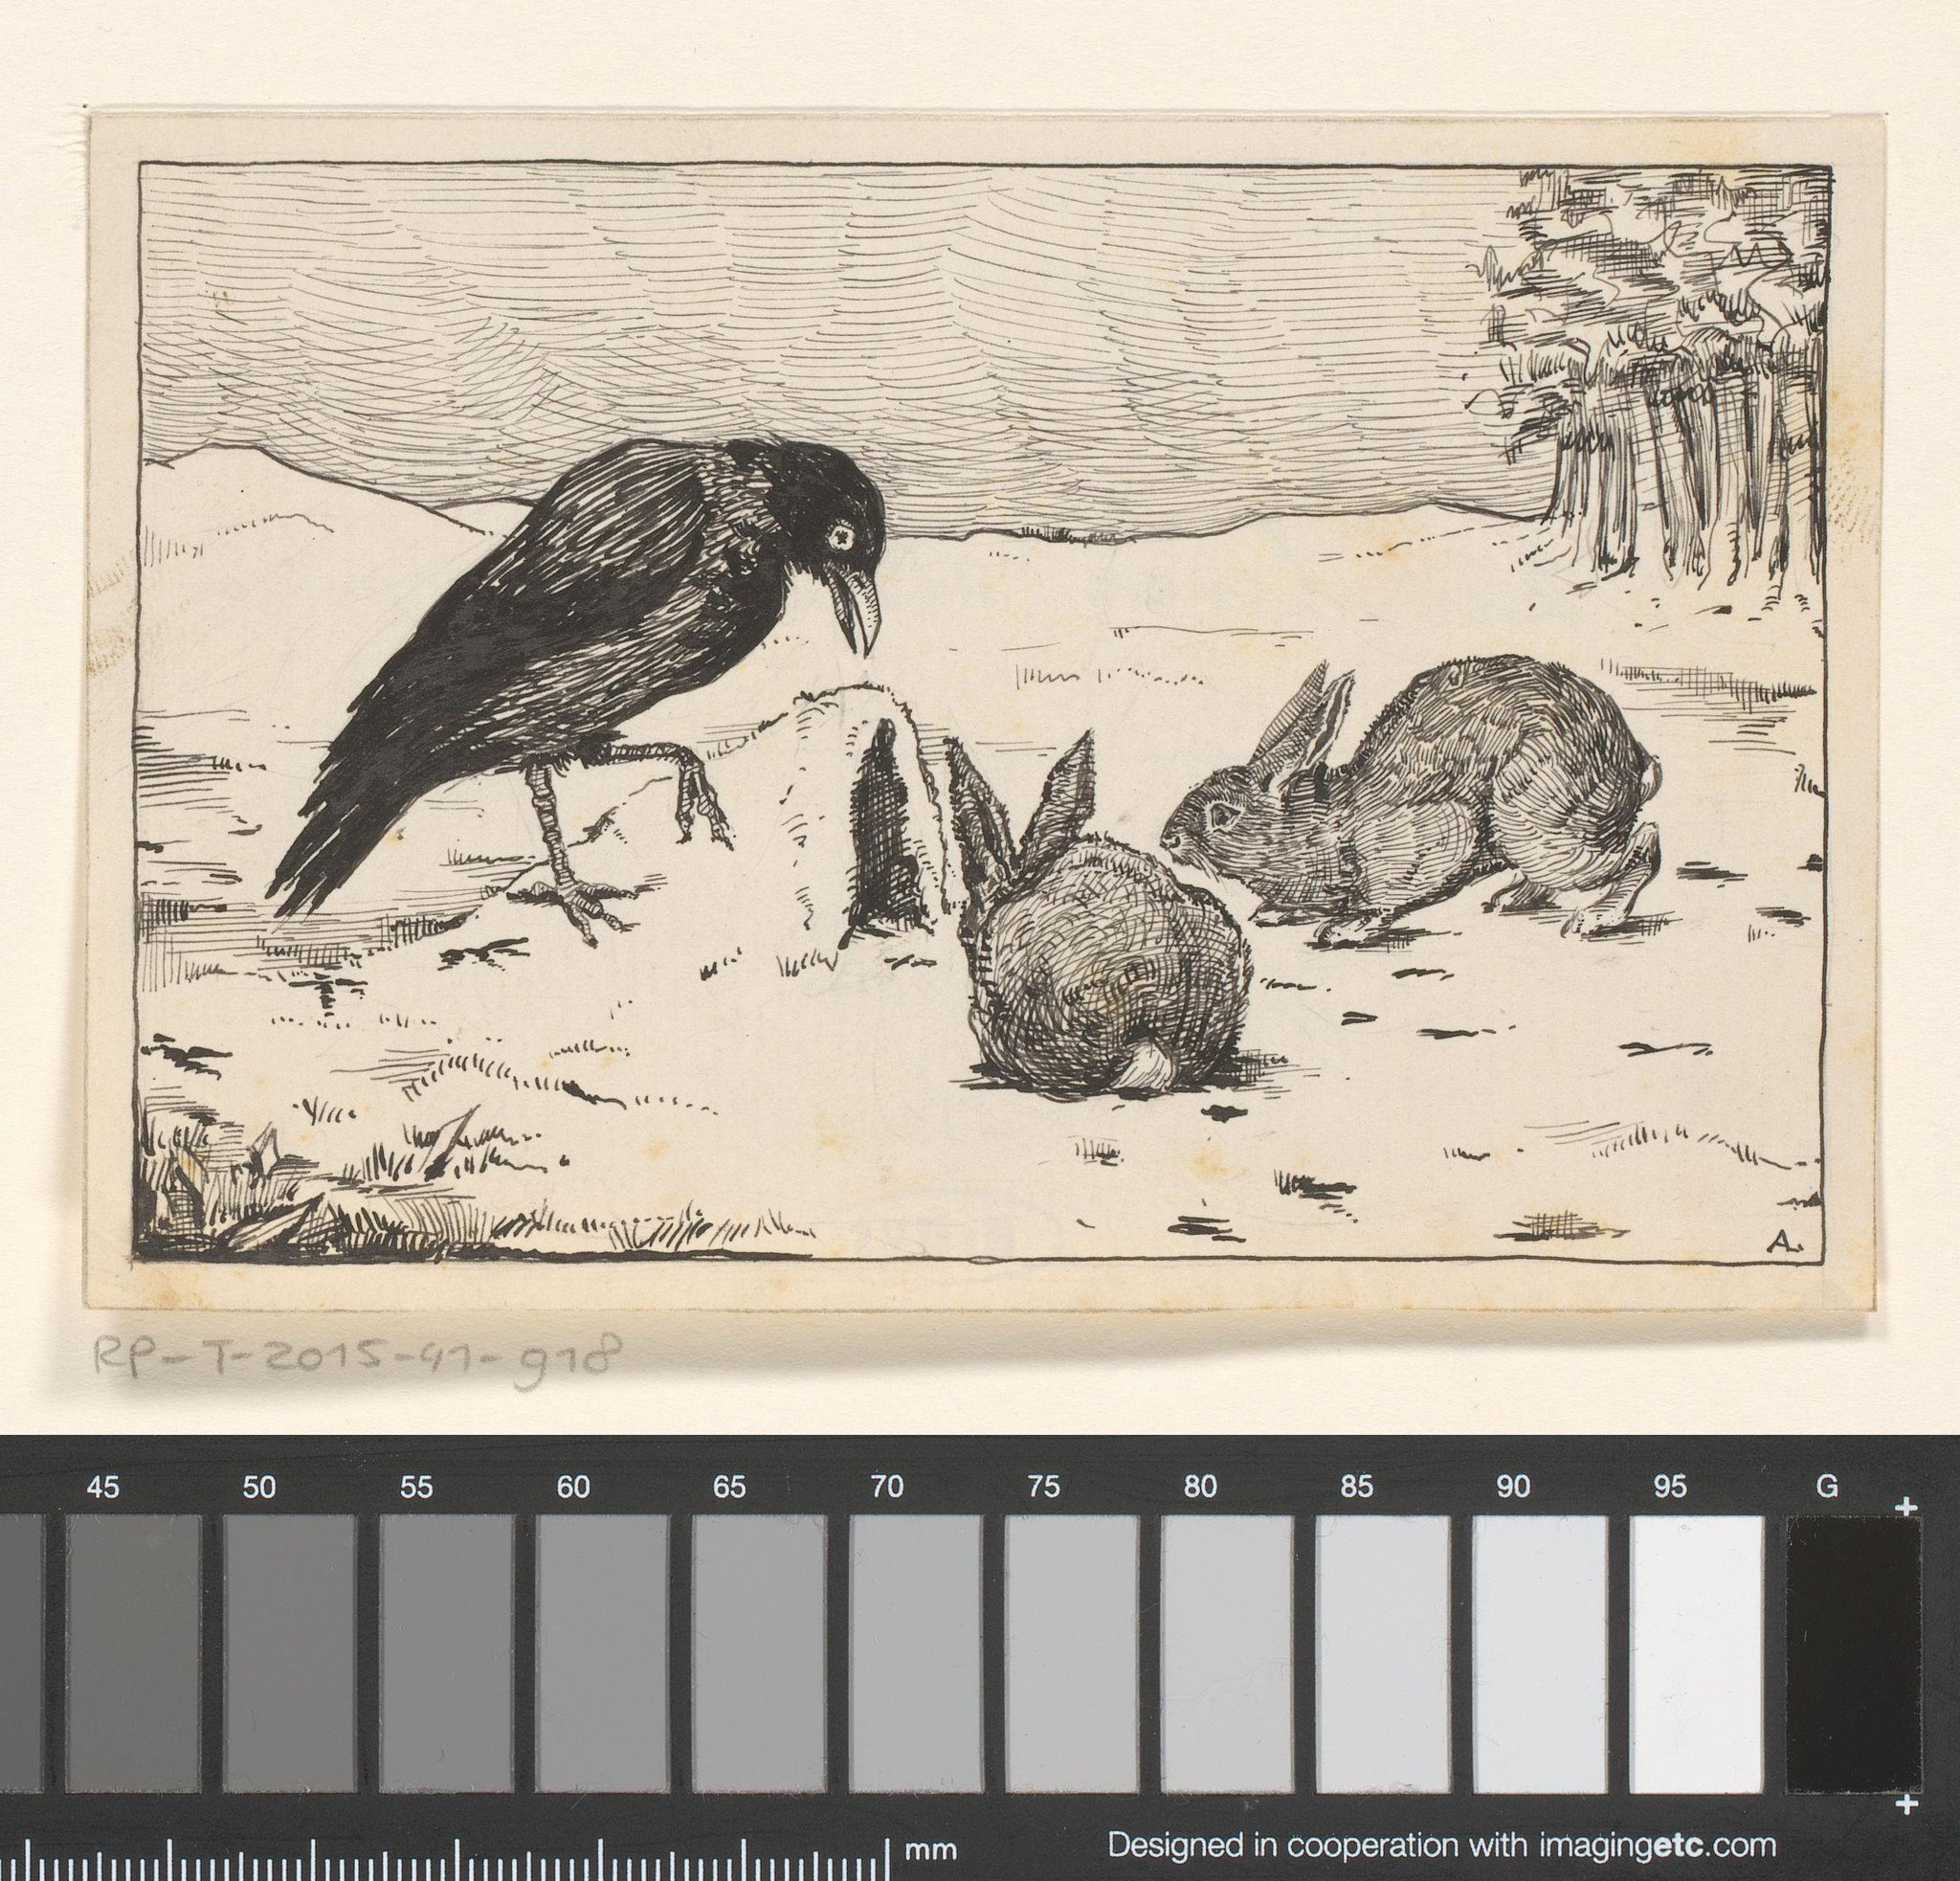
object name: drawing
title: Kraai en twee konijnen bij een hol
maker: adri ladenius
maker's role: draughtsman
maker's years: 1883-1953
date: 1893-1953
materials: ink, paper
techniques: pen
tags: song-birds: crow, rodents: rabbit (+ nest, den, burrow), rodents: rabbit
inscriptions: signature: ‘A.’, collector's mark: Lugt 2228, :, annotation: ‘IV/ Van twee stoute konijntjes’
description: In een landschap zitten twee konijnen en een kraai voor een hol. In de achtergrond een bomengroep.